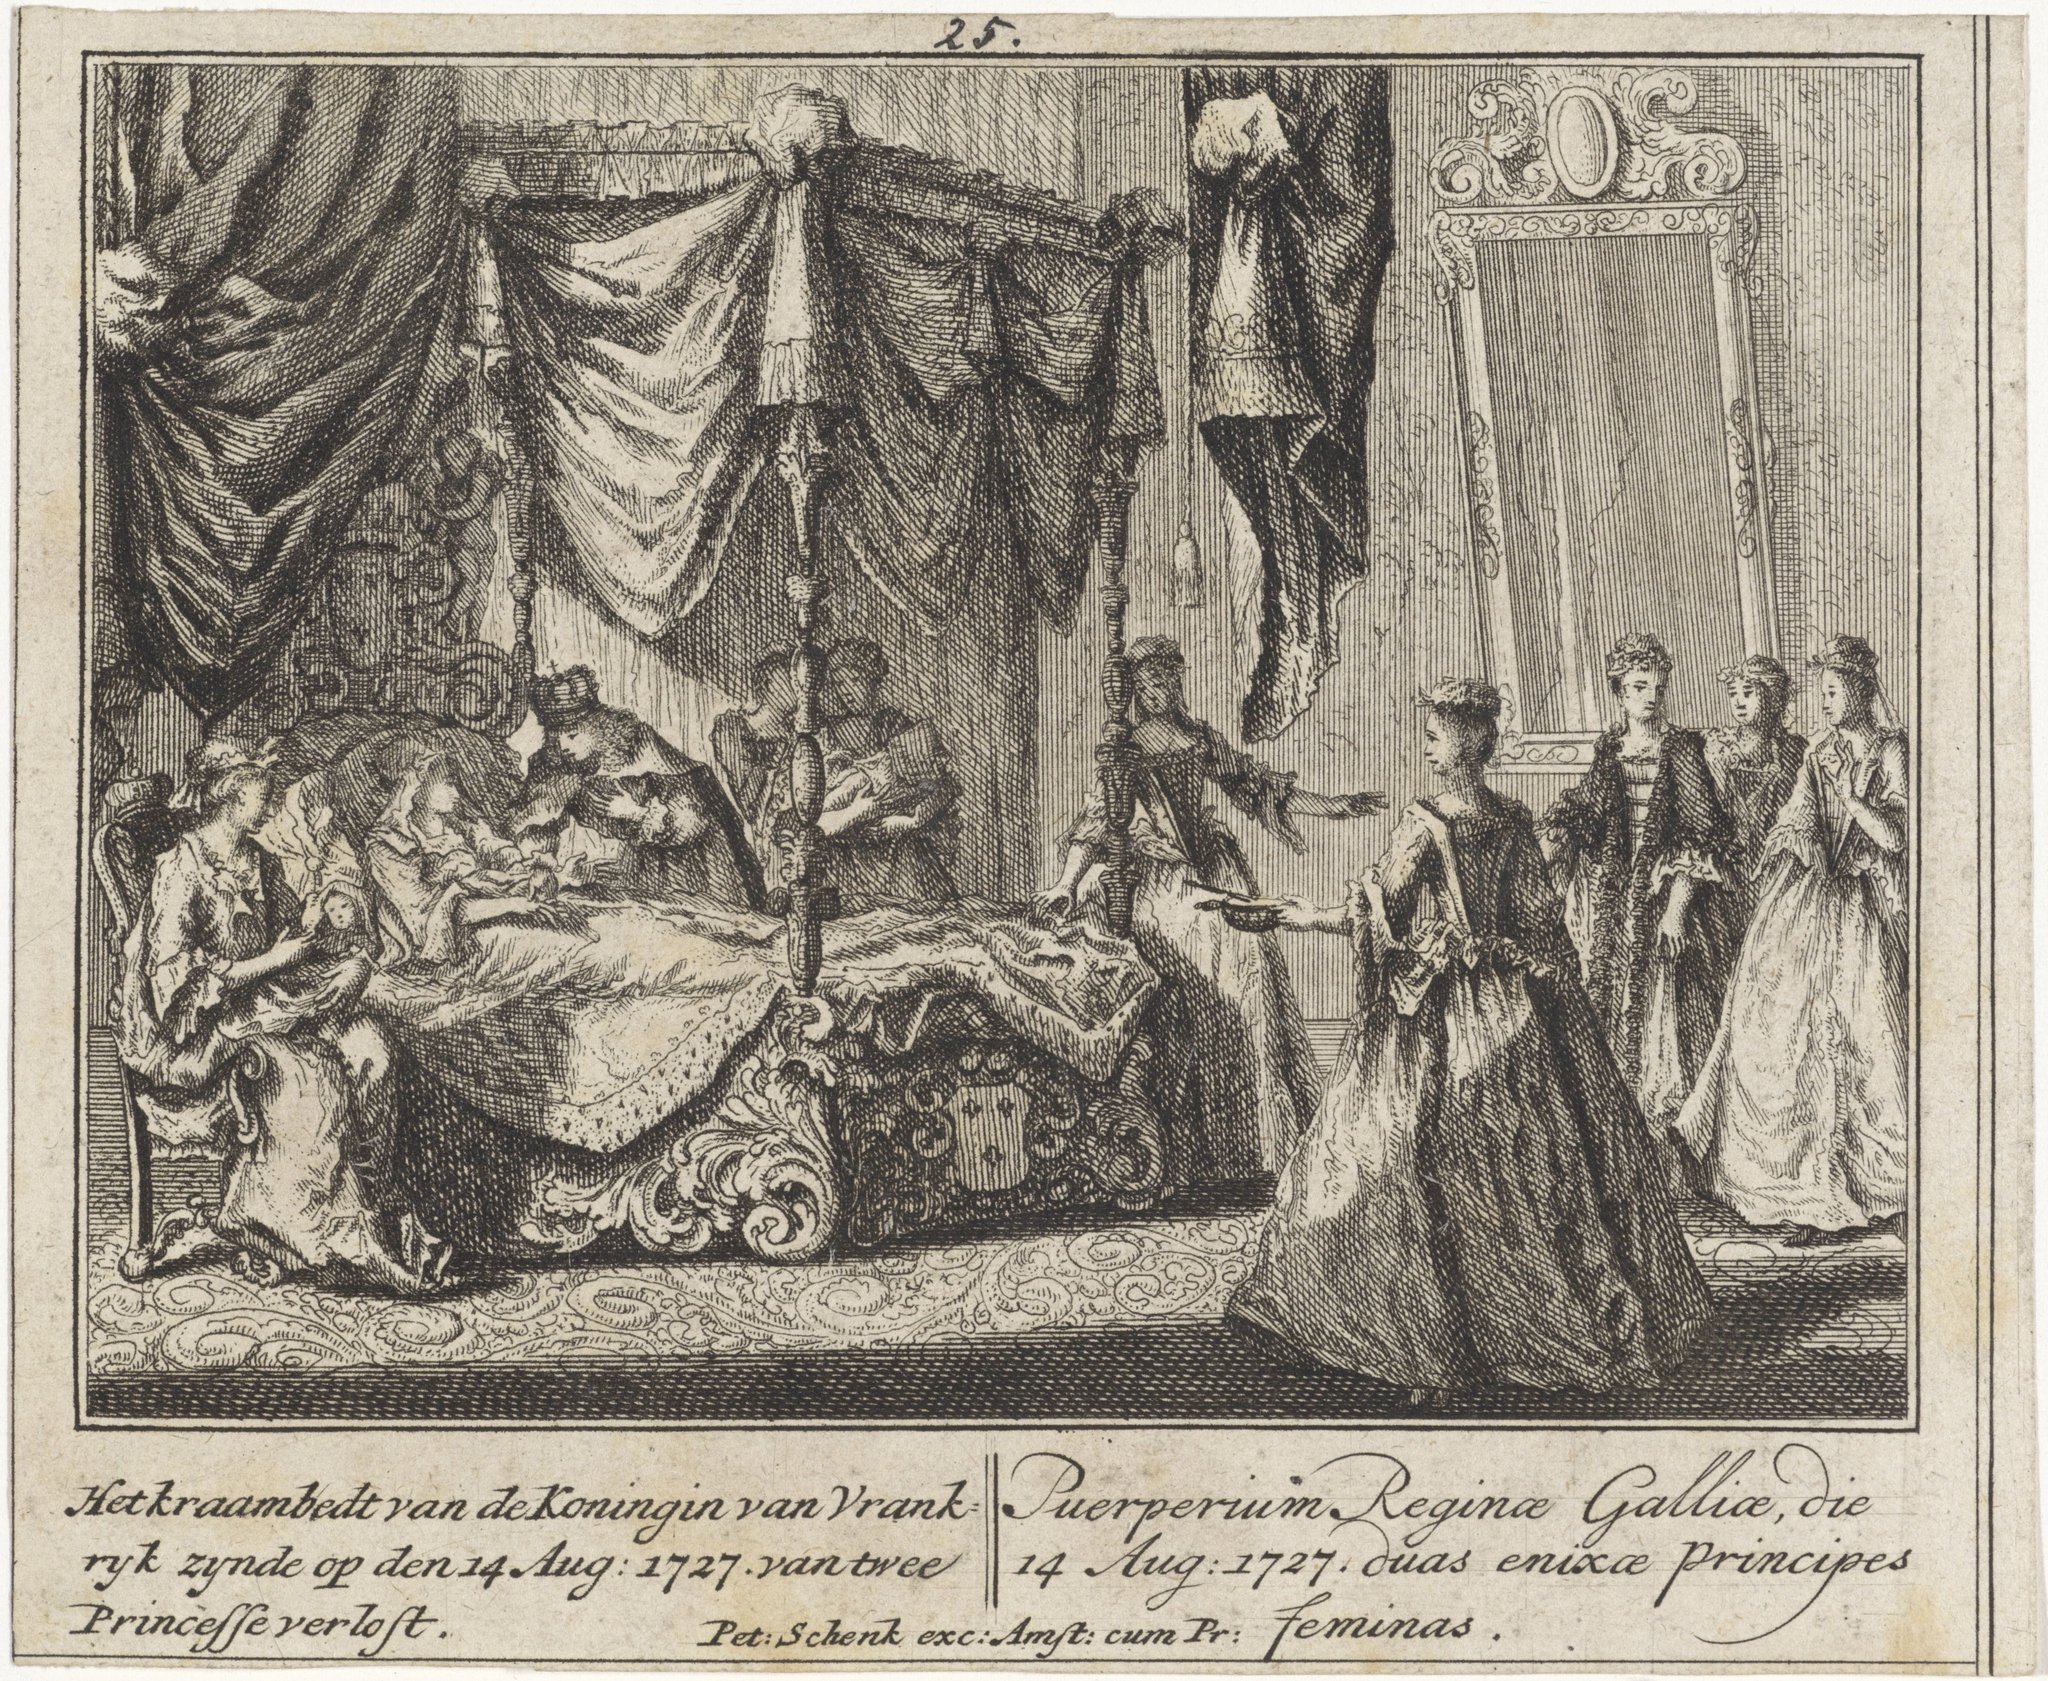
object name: book illustration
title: Maria Lesczinska in het kraambed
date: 1727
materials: paper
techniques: etching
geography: amsterdam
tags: maria lesczinska (koningin van frankrijk), louis xv of france, visiting the new mother, lying-in visit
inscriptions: collector's mark: Lugt 2228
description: Maria Lesczinska, koningin van Frankrijk, ligt in het kraambed na de bevalling van haar tweelingdochters Marie Louise Elisabeth en Henriëtte Anne. Links zit een hofdame met één van de kinderen op haar schoot. Haar man Lodewijk XV buigt zich over haar heen. Enkele hovelingen brengen haar een bezoek. Linksonder een drieregelige tekst in het Nederlands met een toelichting op de voorstelling en rechts een vergelijkbare toelichting in het Latijn.